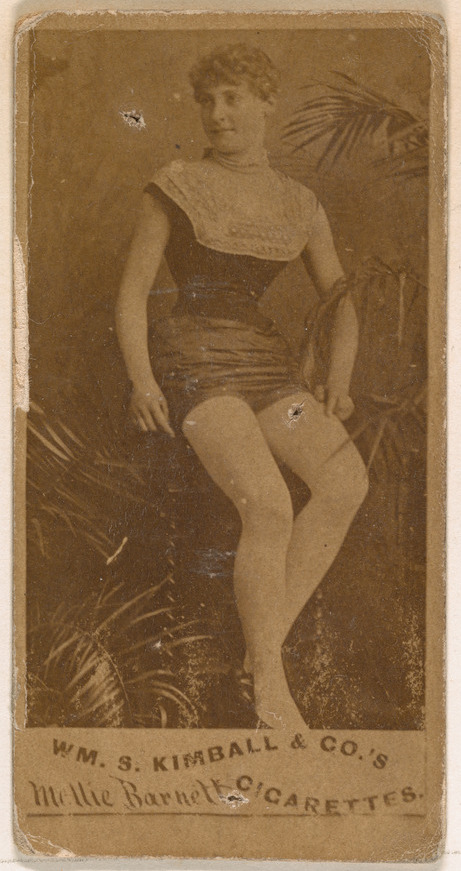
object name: photograph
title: Millie Barnett, from the Actresses series (N203) issued by Wm. S. Kimball & Co.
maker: william s. kimball & company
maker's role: publisher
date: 1889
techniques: color lithograph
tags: portraits,women,actresses